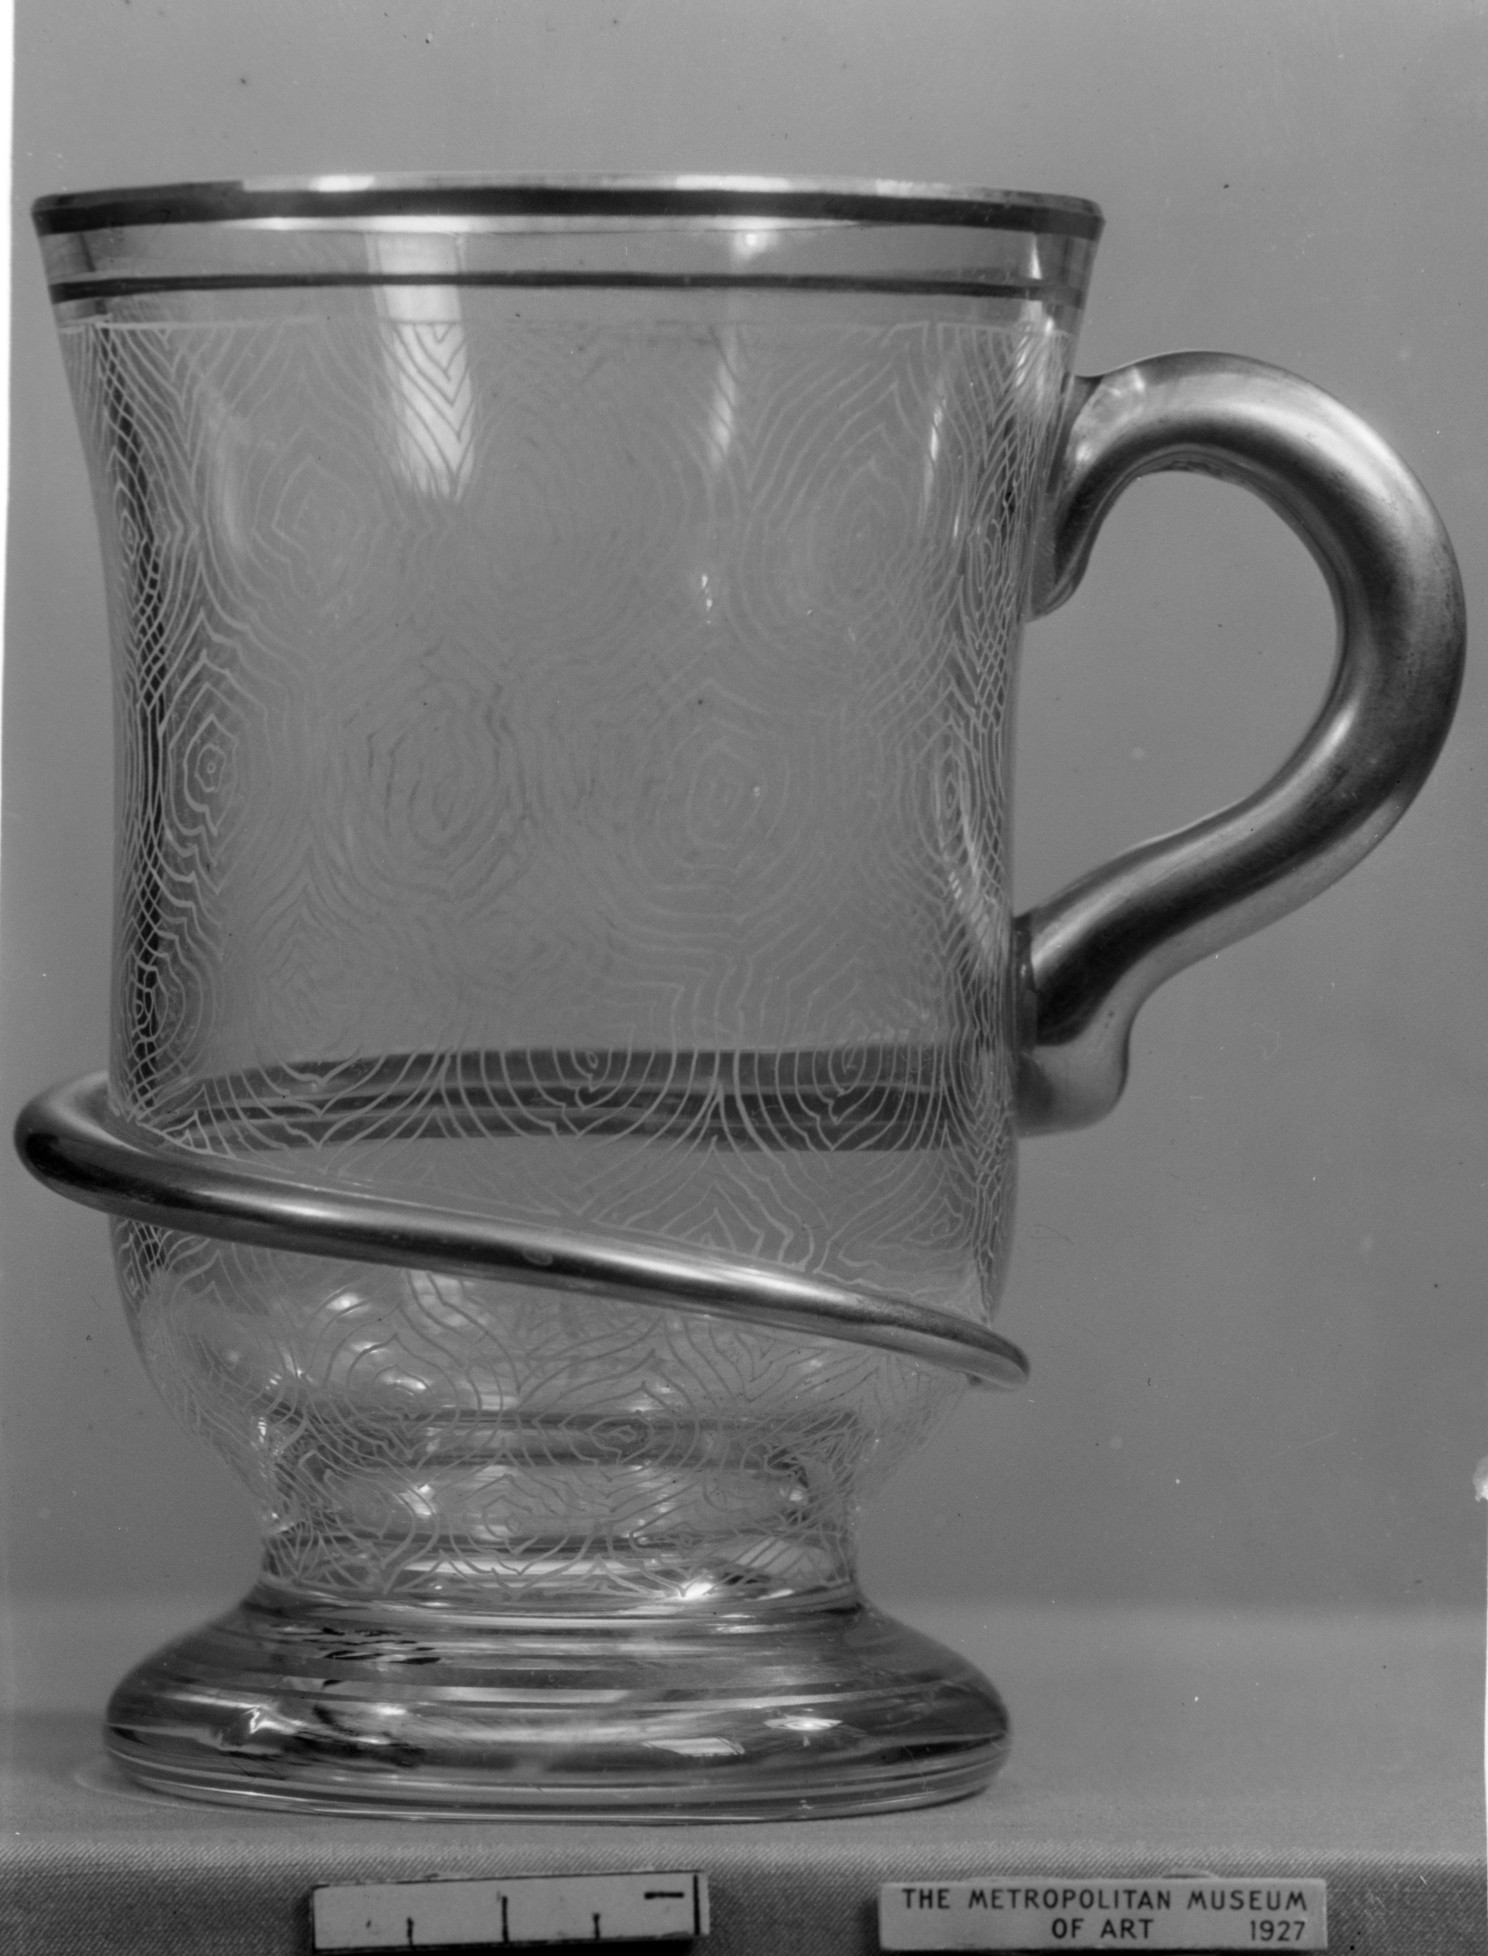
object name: mug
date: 1840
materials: gilt, glass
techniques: enamel